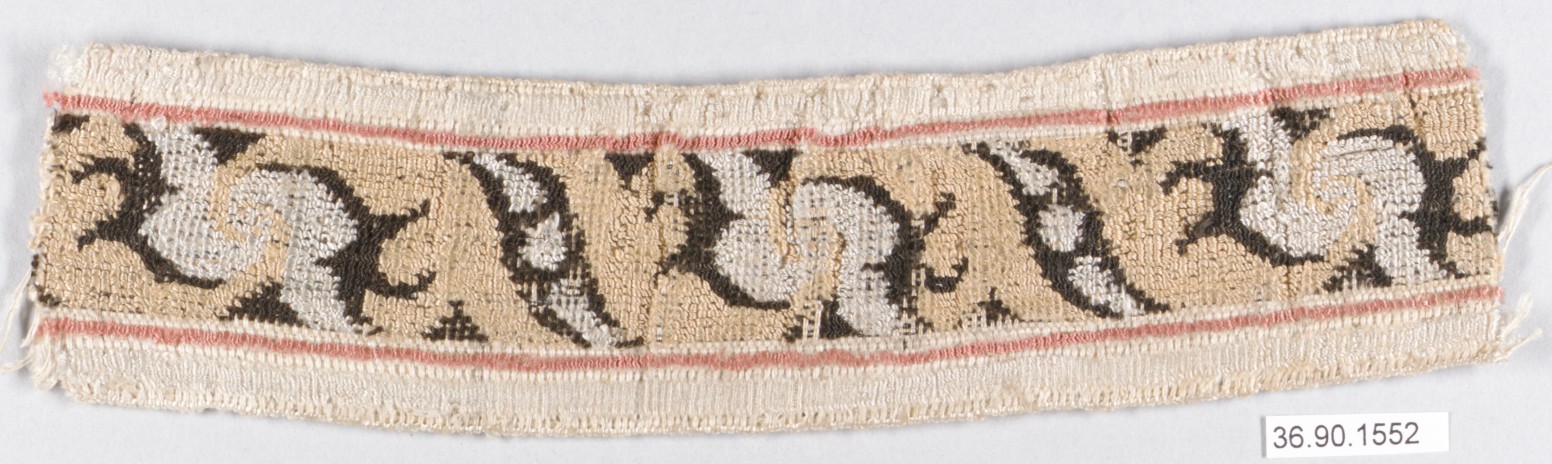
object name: galloon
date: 1701-1900